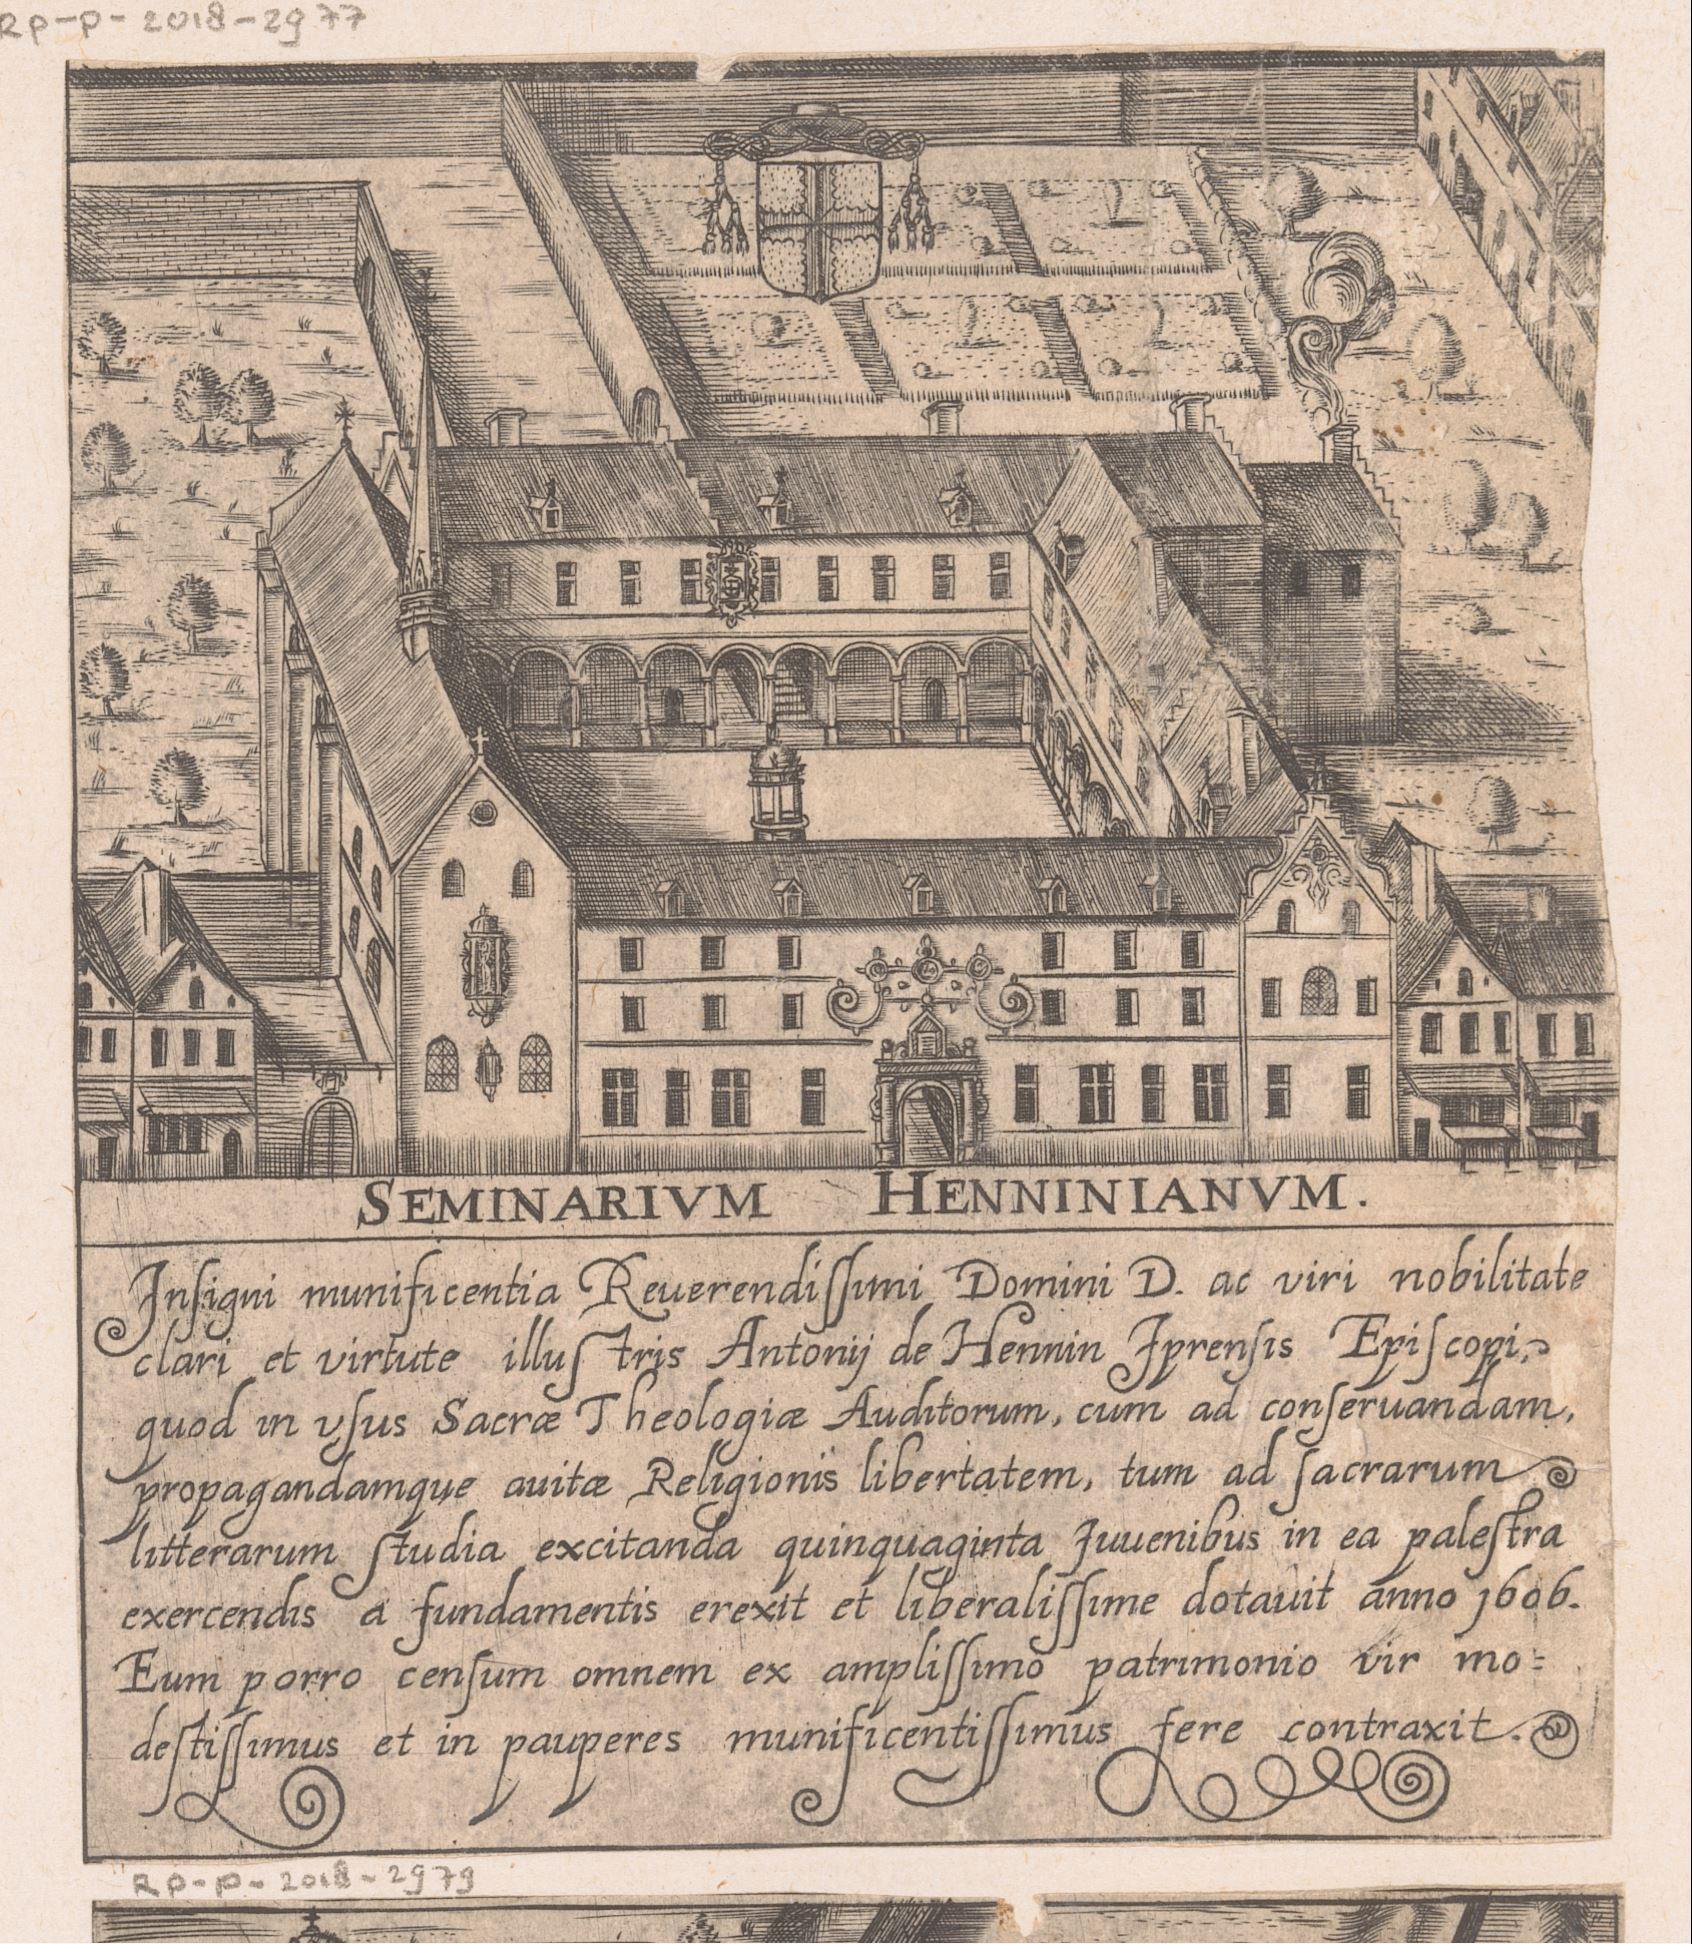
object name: print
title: Seminarium Henninianum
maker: filippo ferrari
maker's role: print maker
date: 1605-1680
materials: paper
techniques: etching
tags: prospect of city, town panorama, silhouette of city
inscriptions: collector's mark: Lugt 2228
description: Onderdeel van een reeks gezichten op steden/gebouwen met bijbehorend voorblad met tekst en legenda. De legendanummers zijn naast de afbeeldingen bijgeschreven. De afbeeldingen zijn per zes op één blad bevestigd.